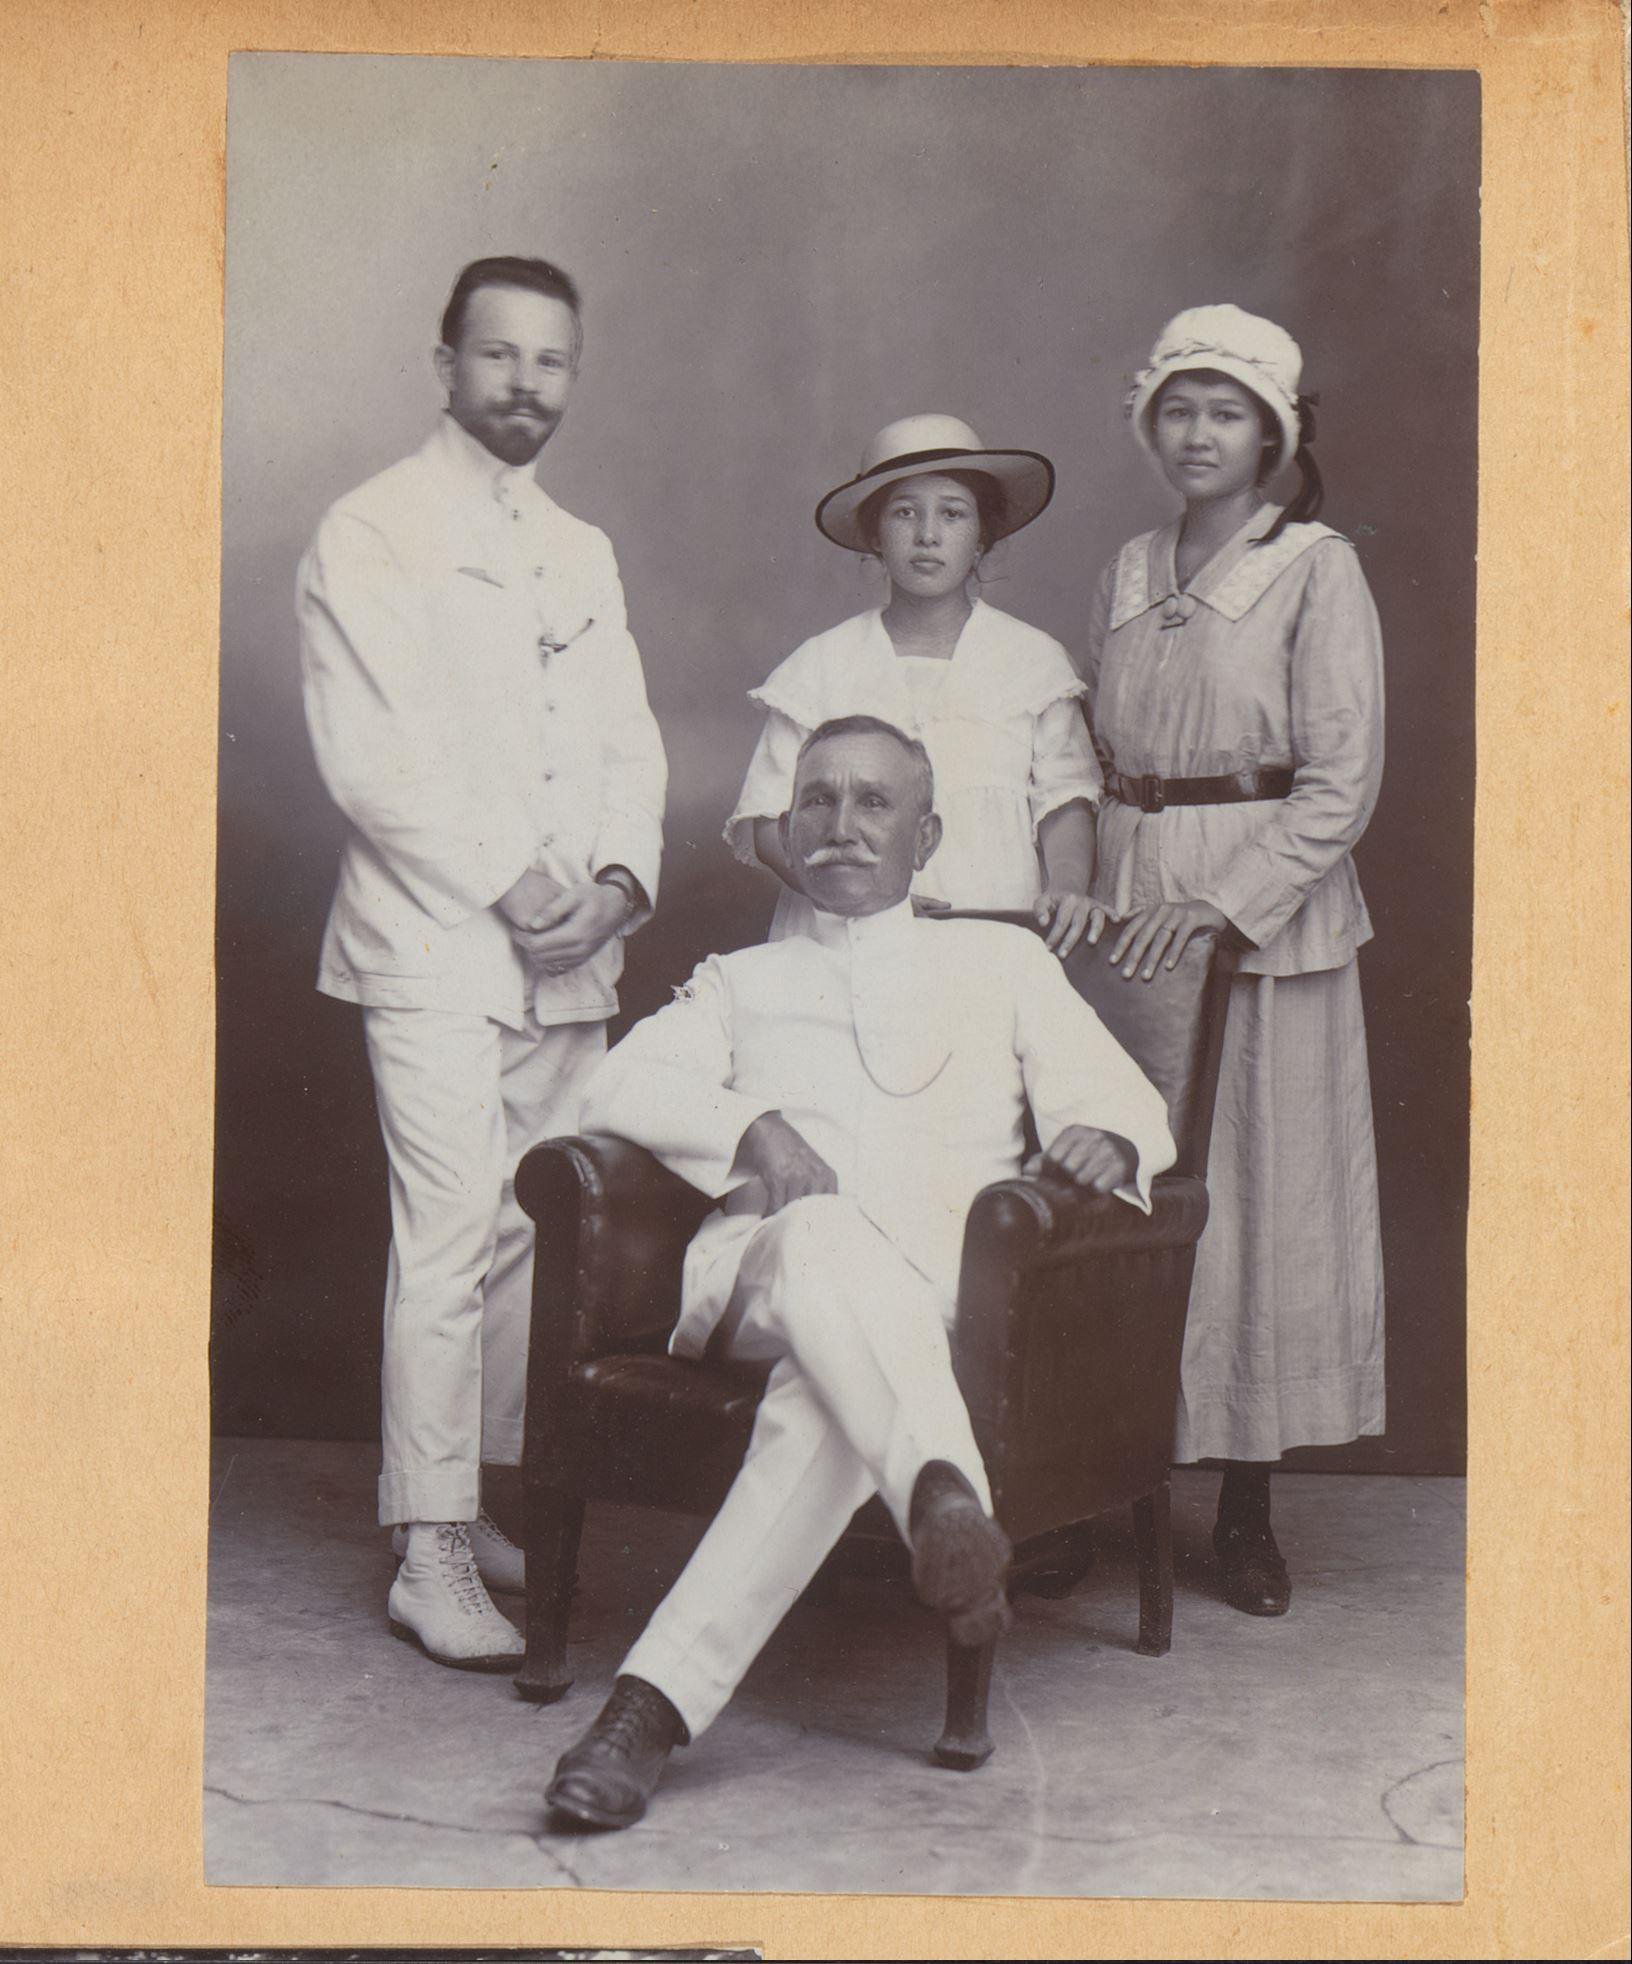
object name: photograph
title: Groepsportret van (mogelijk) een bestuursambtenaar en zijn familie in Nederlands-Indië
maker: Anonymous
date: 1917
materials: photographic support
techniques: gelatin silver print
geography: dutch east indies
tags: official; civil servant; functionary (in general), family group, especially parents with their child(ren), dutch east indies, the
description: Onderdeel van Familiealbum met foto's van een familie in de voormalige kolonie Nederlands-Indië en van een suikerfabriek in Purworejo.